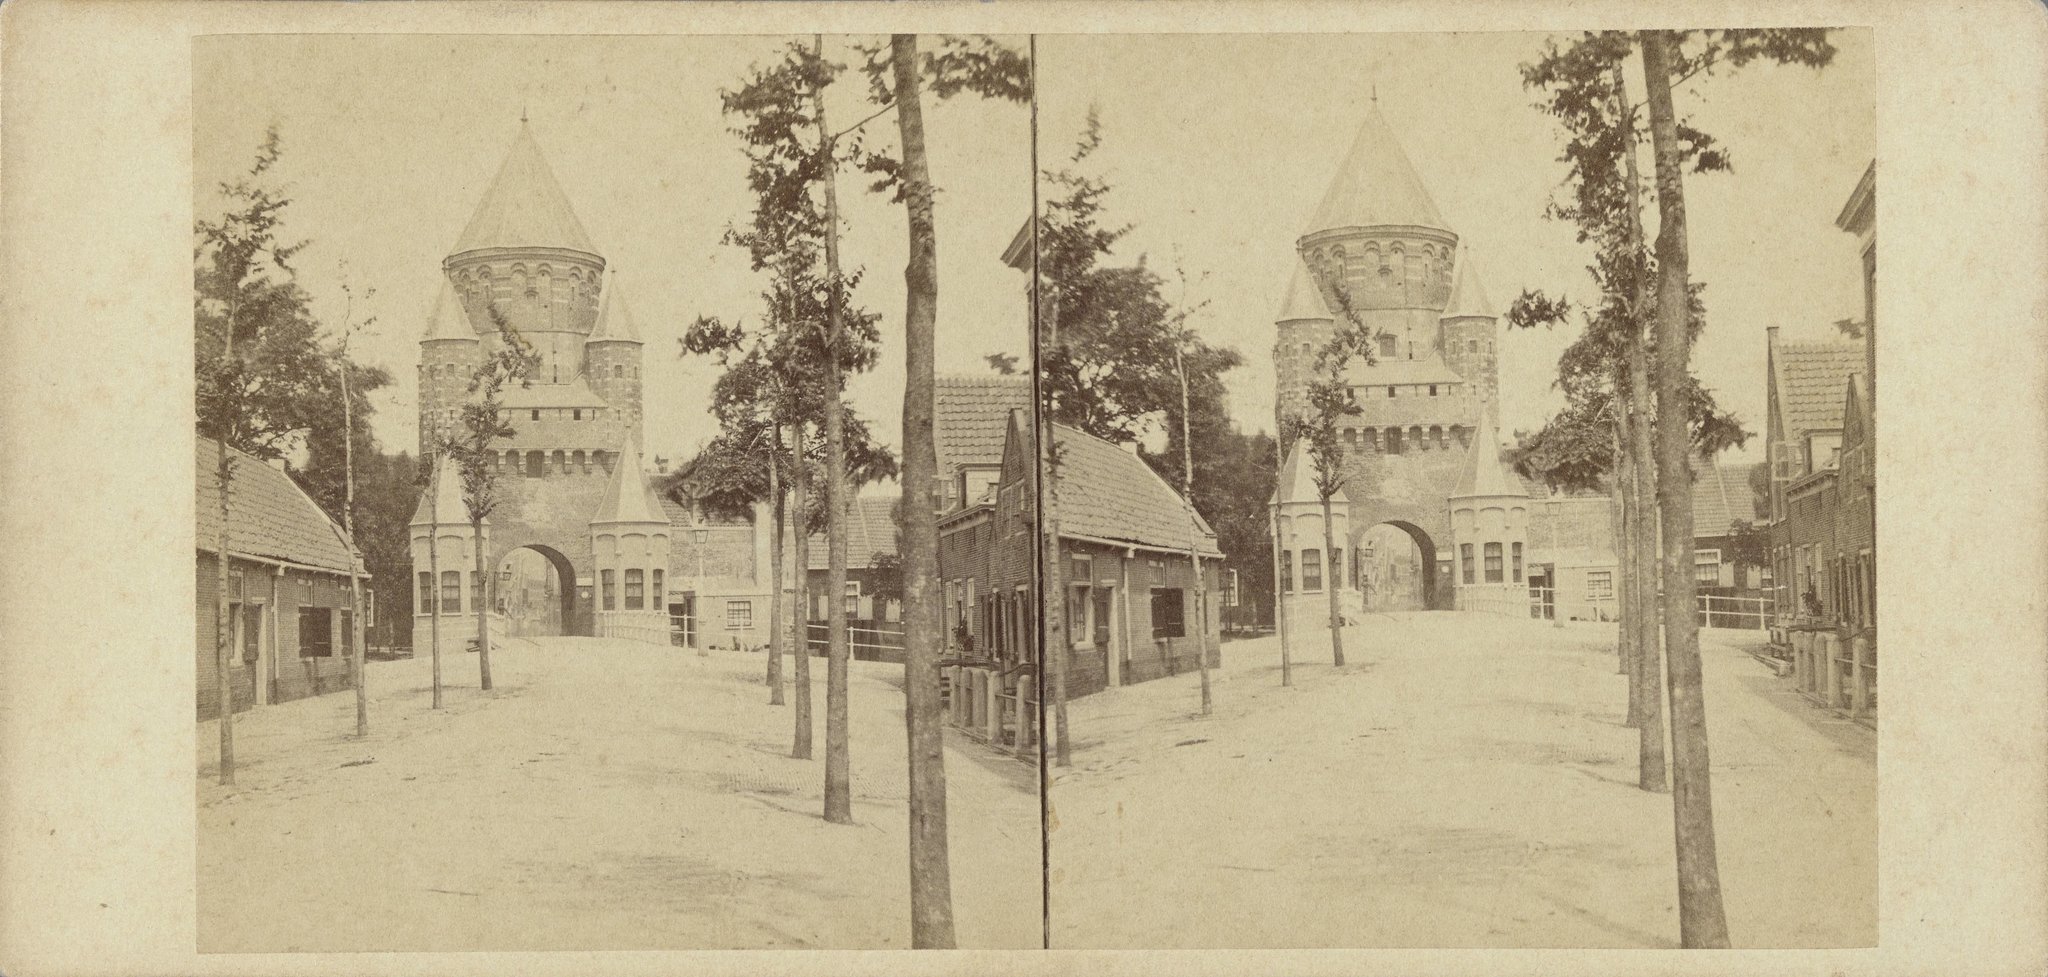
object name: stereograph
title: Gezicht op de Kleine Houtpoort in Haarlem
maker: Anonymous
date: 1860-1873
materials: cardboard, paper, photographic support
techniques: albumen print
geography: haarlem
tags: city-gate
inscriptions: inscription: ‘Vues de Hollande. Haarlem. Kleine Houtpoort No. 187’